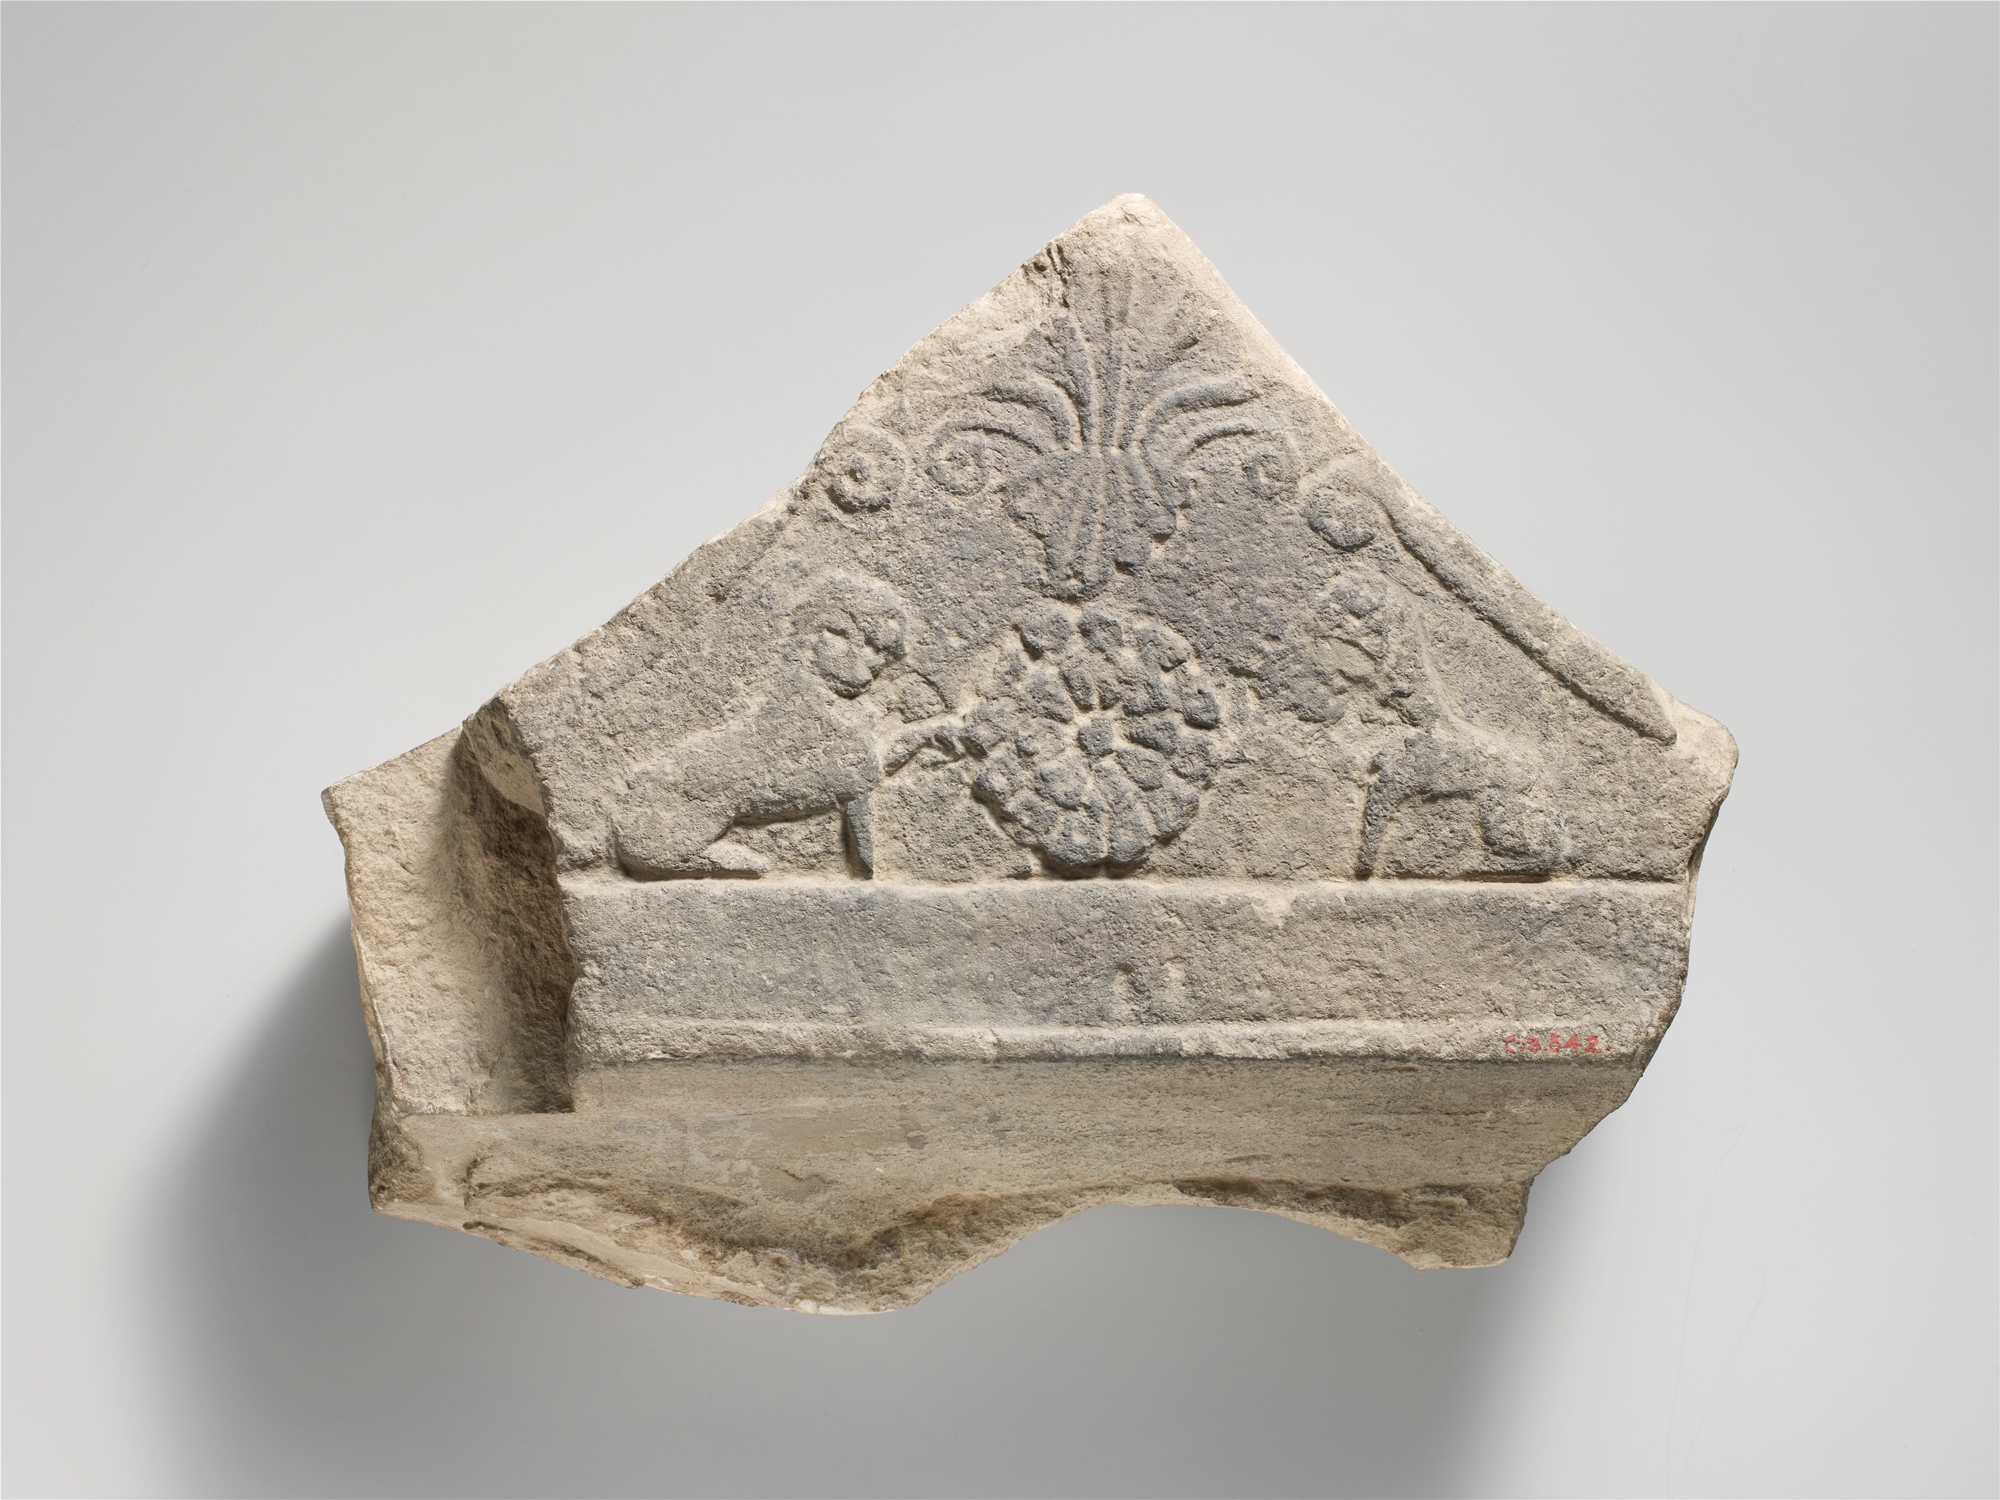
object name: relief fragment with lion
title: Limestone finial of a funerary stele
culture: cypriot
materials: limestone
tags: lions